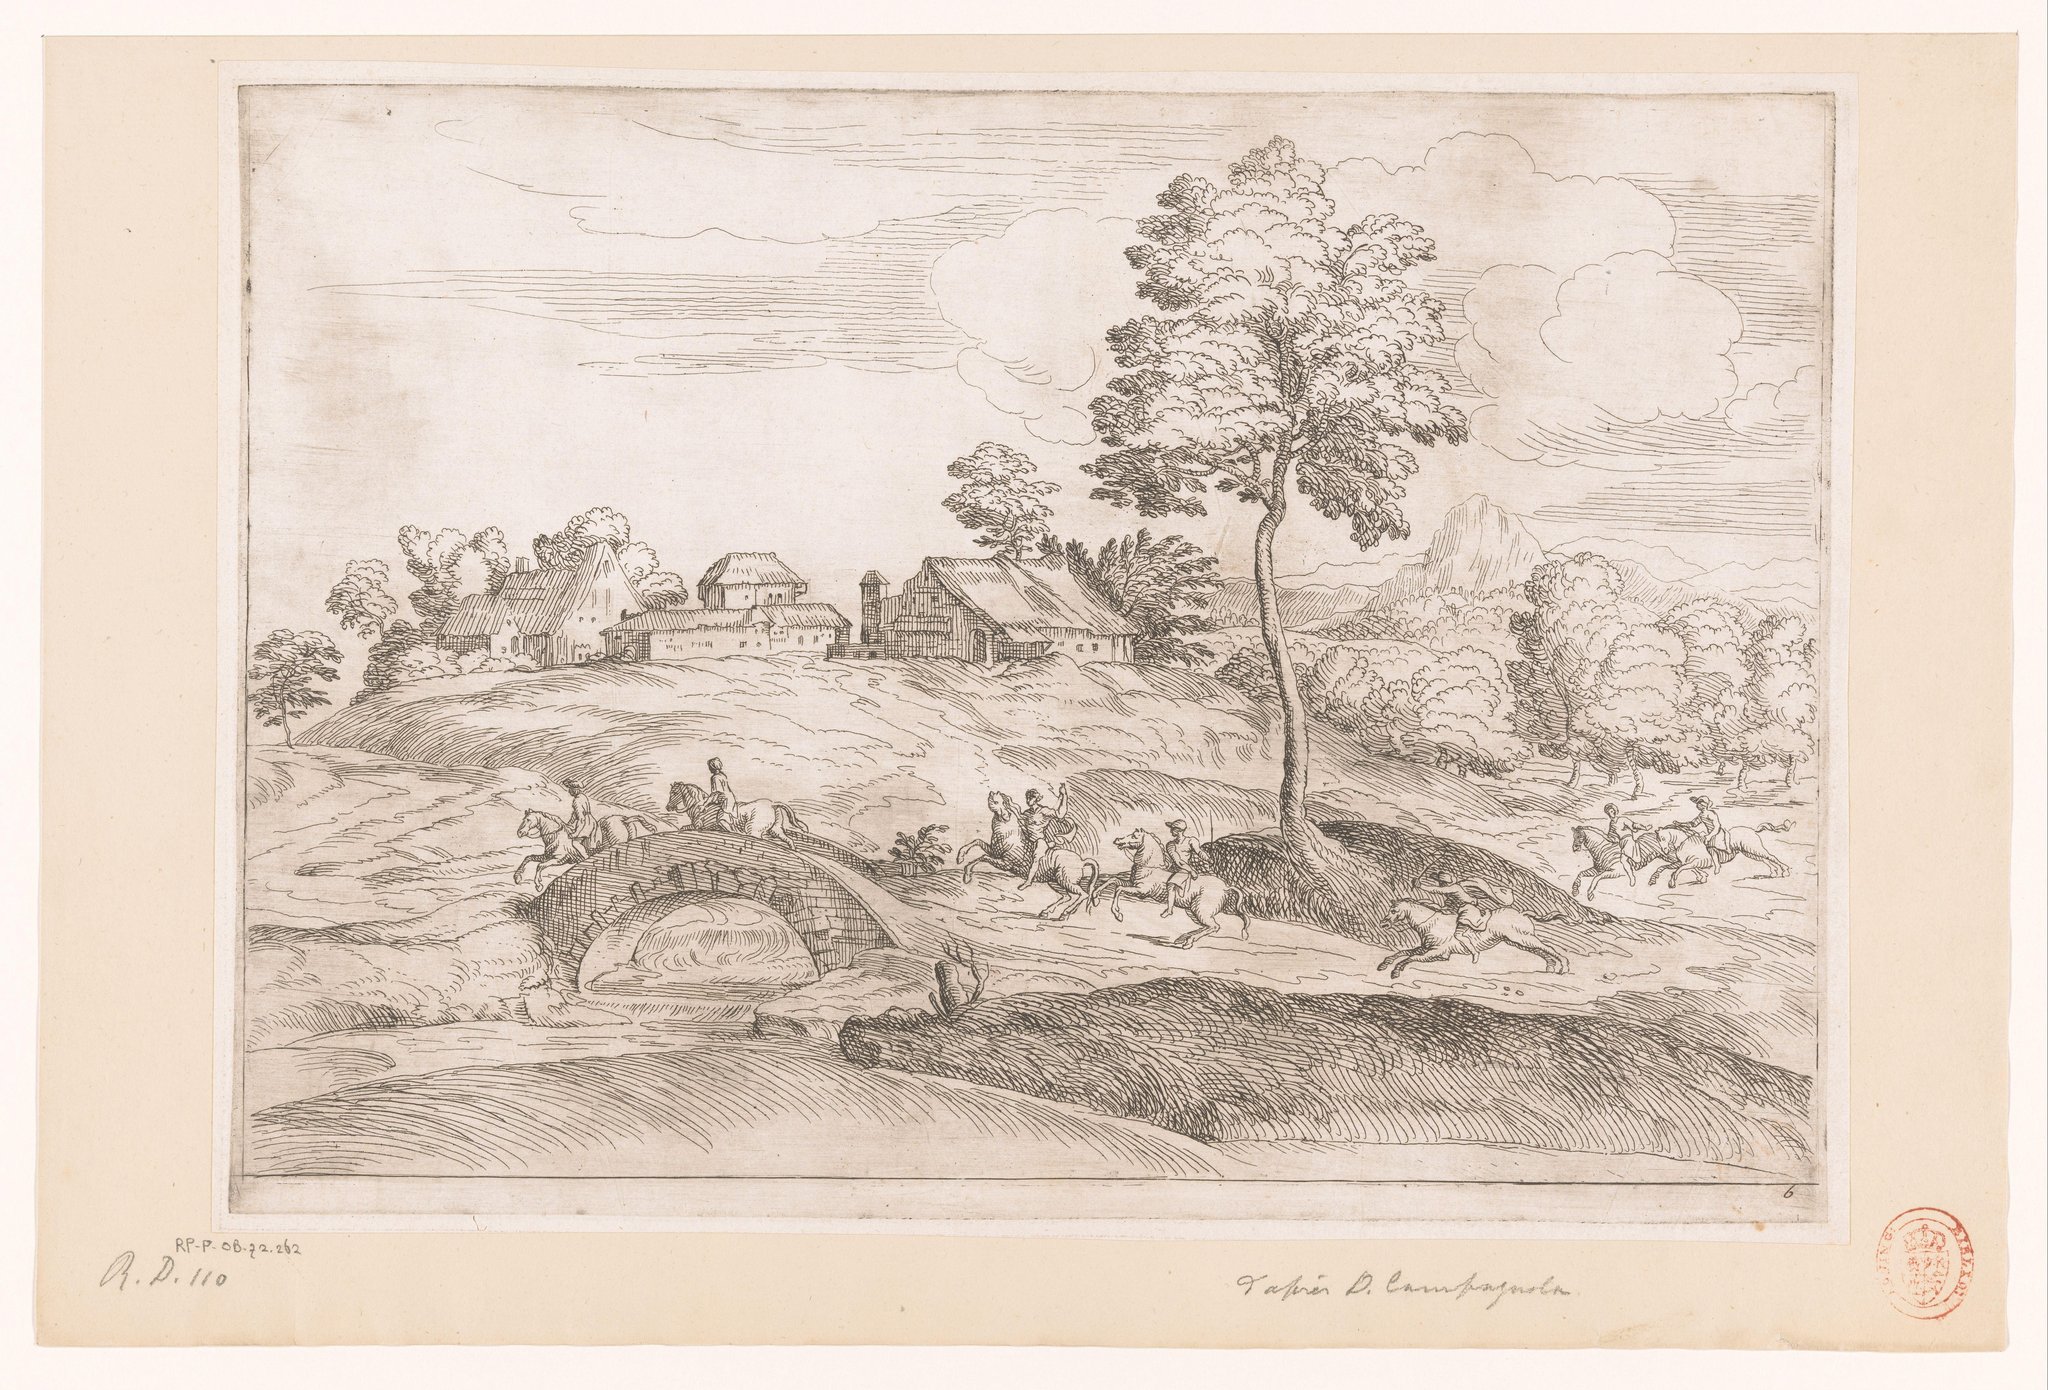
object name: print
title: Prenten naar tekeningen uit het kabinet Jabach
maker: jean pesne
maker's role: print maker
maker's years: 1623-1700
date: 1666-1695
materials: paper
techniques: etching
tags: riding a horse, ass, or mule; rider, horseman, landscape with bridge, viaduct or aqueduct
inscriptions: collector's mark: Lugt 240, number: ‘6’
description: Prent maakt deel uit van een serie van 283 prenten, ongenummerde staat.